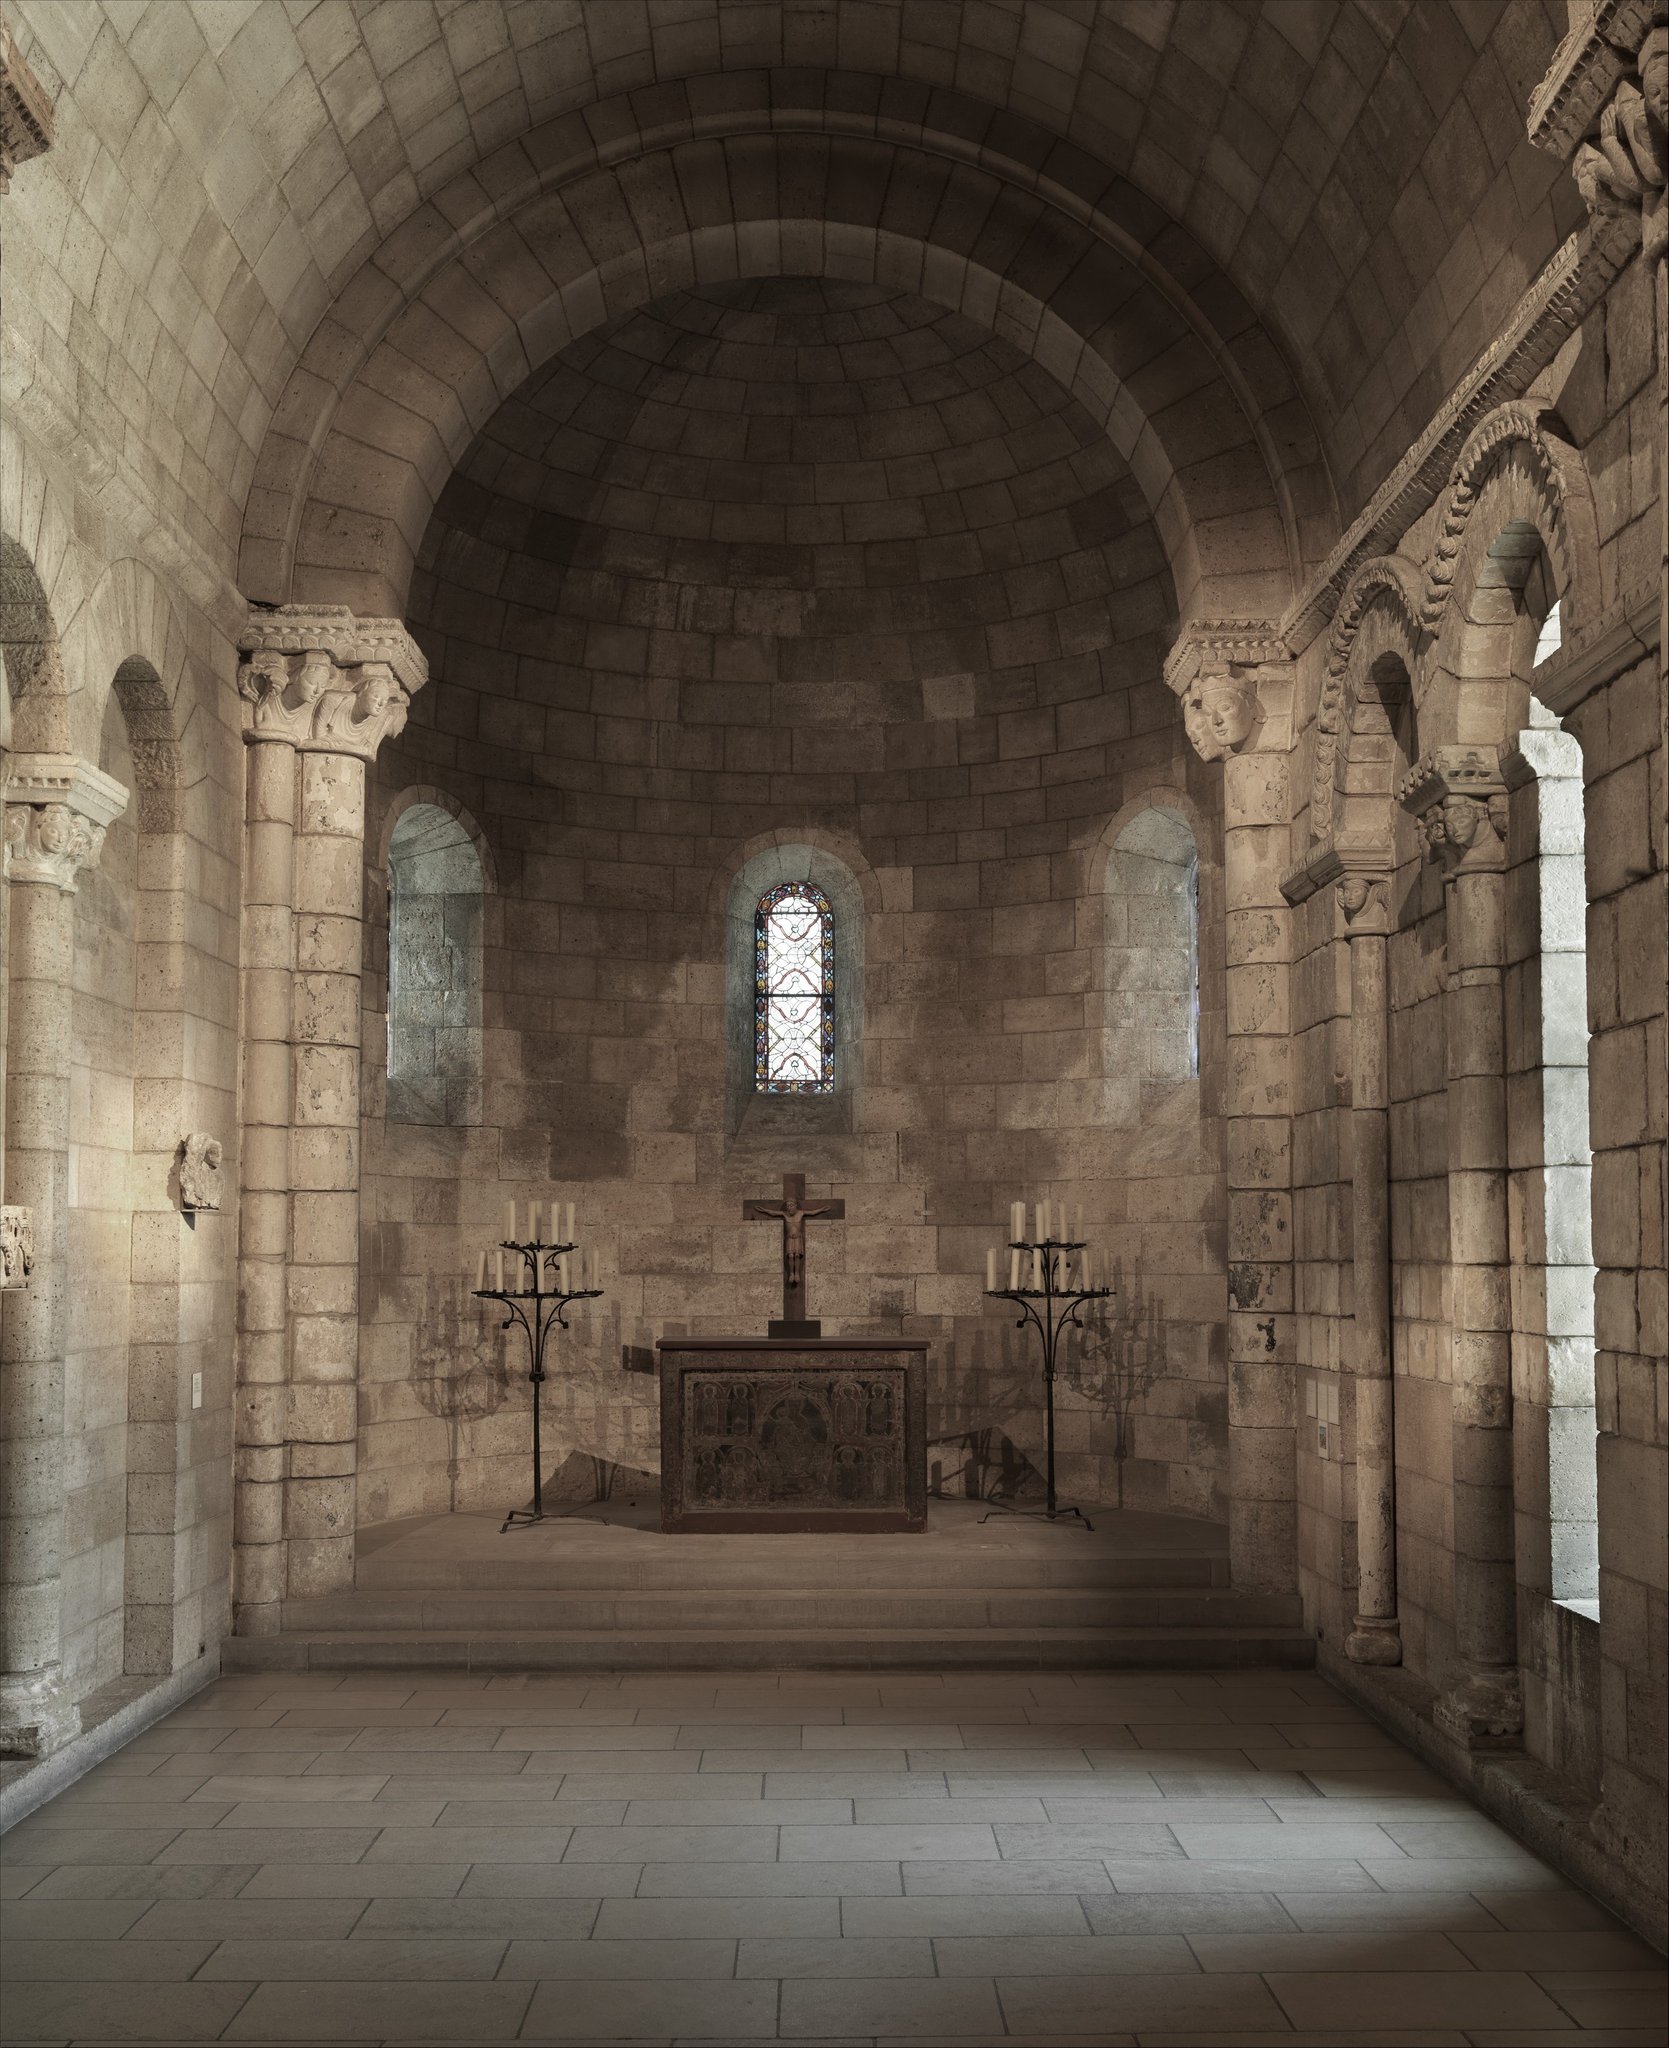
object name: chapel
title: Chapel from Notre-Dame-du-Bourg at Langon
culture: french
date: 1126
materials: limestone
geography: france